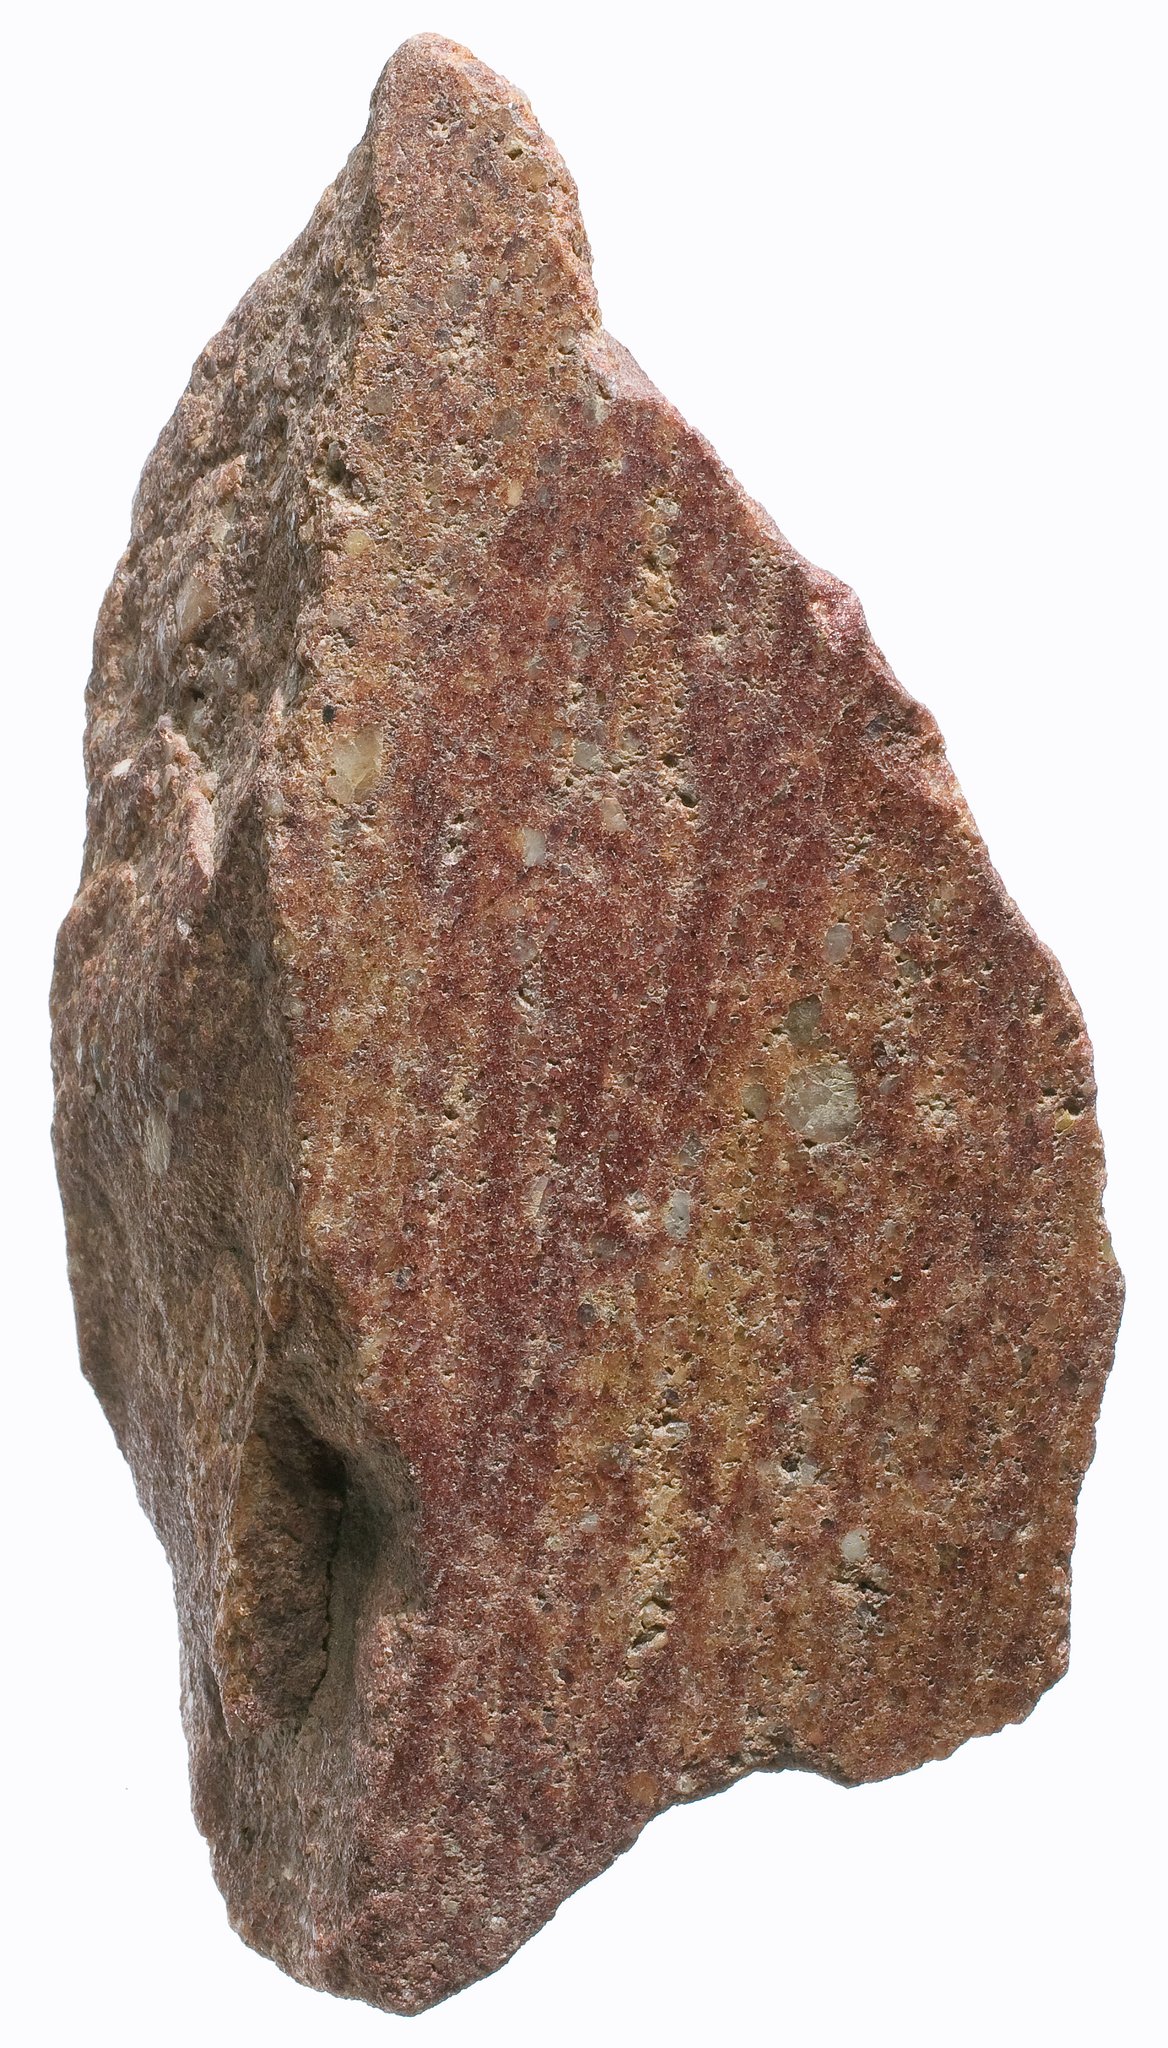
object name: chest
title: chest (?) fragment from a statue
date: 1353-1336 BCE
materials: quartzite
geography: egypt